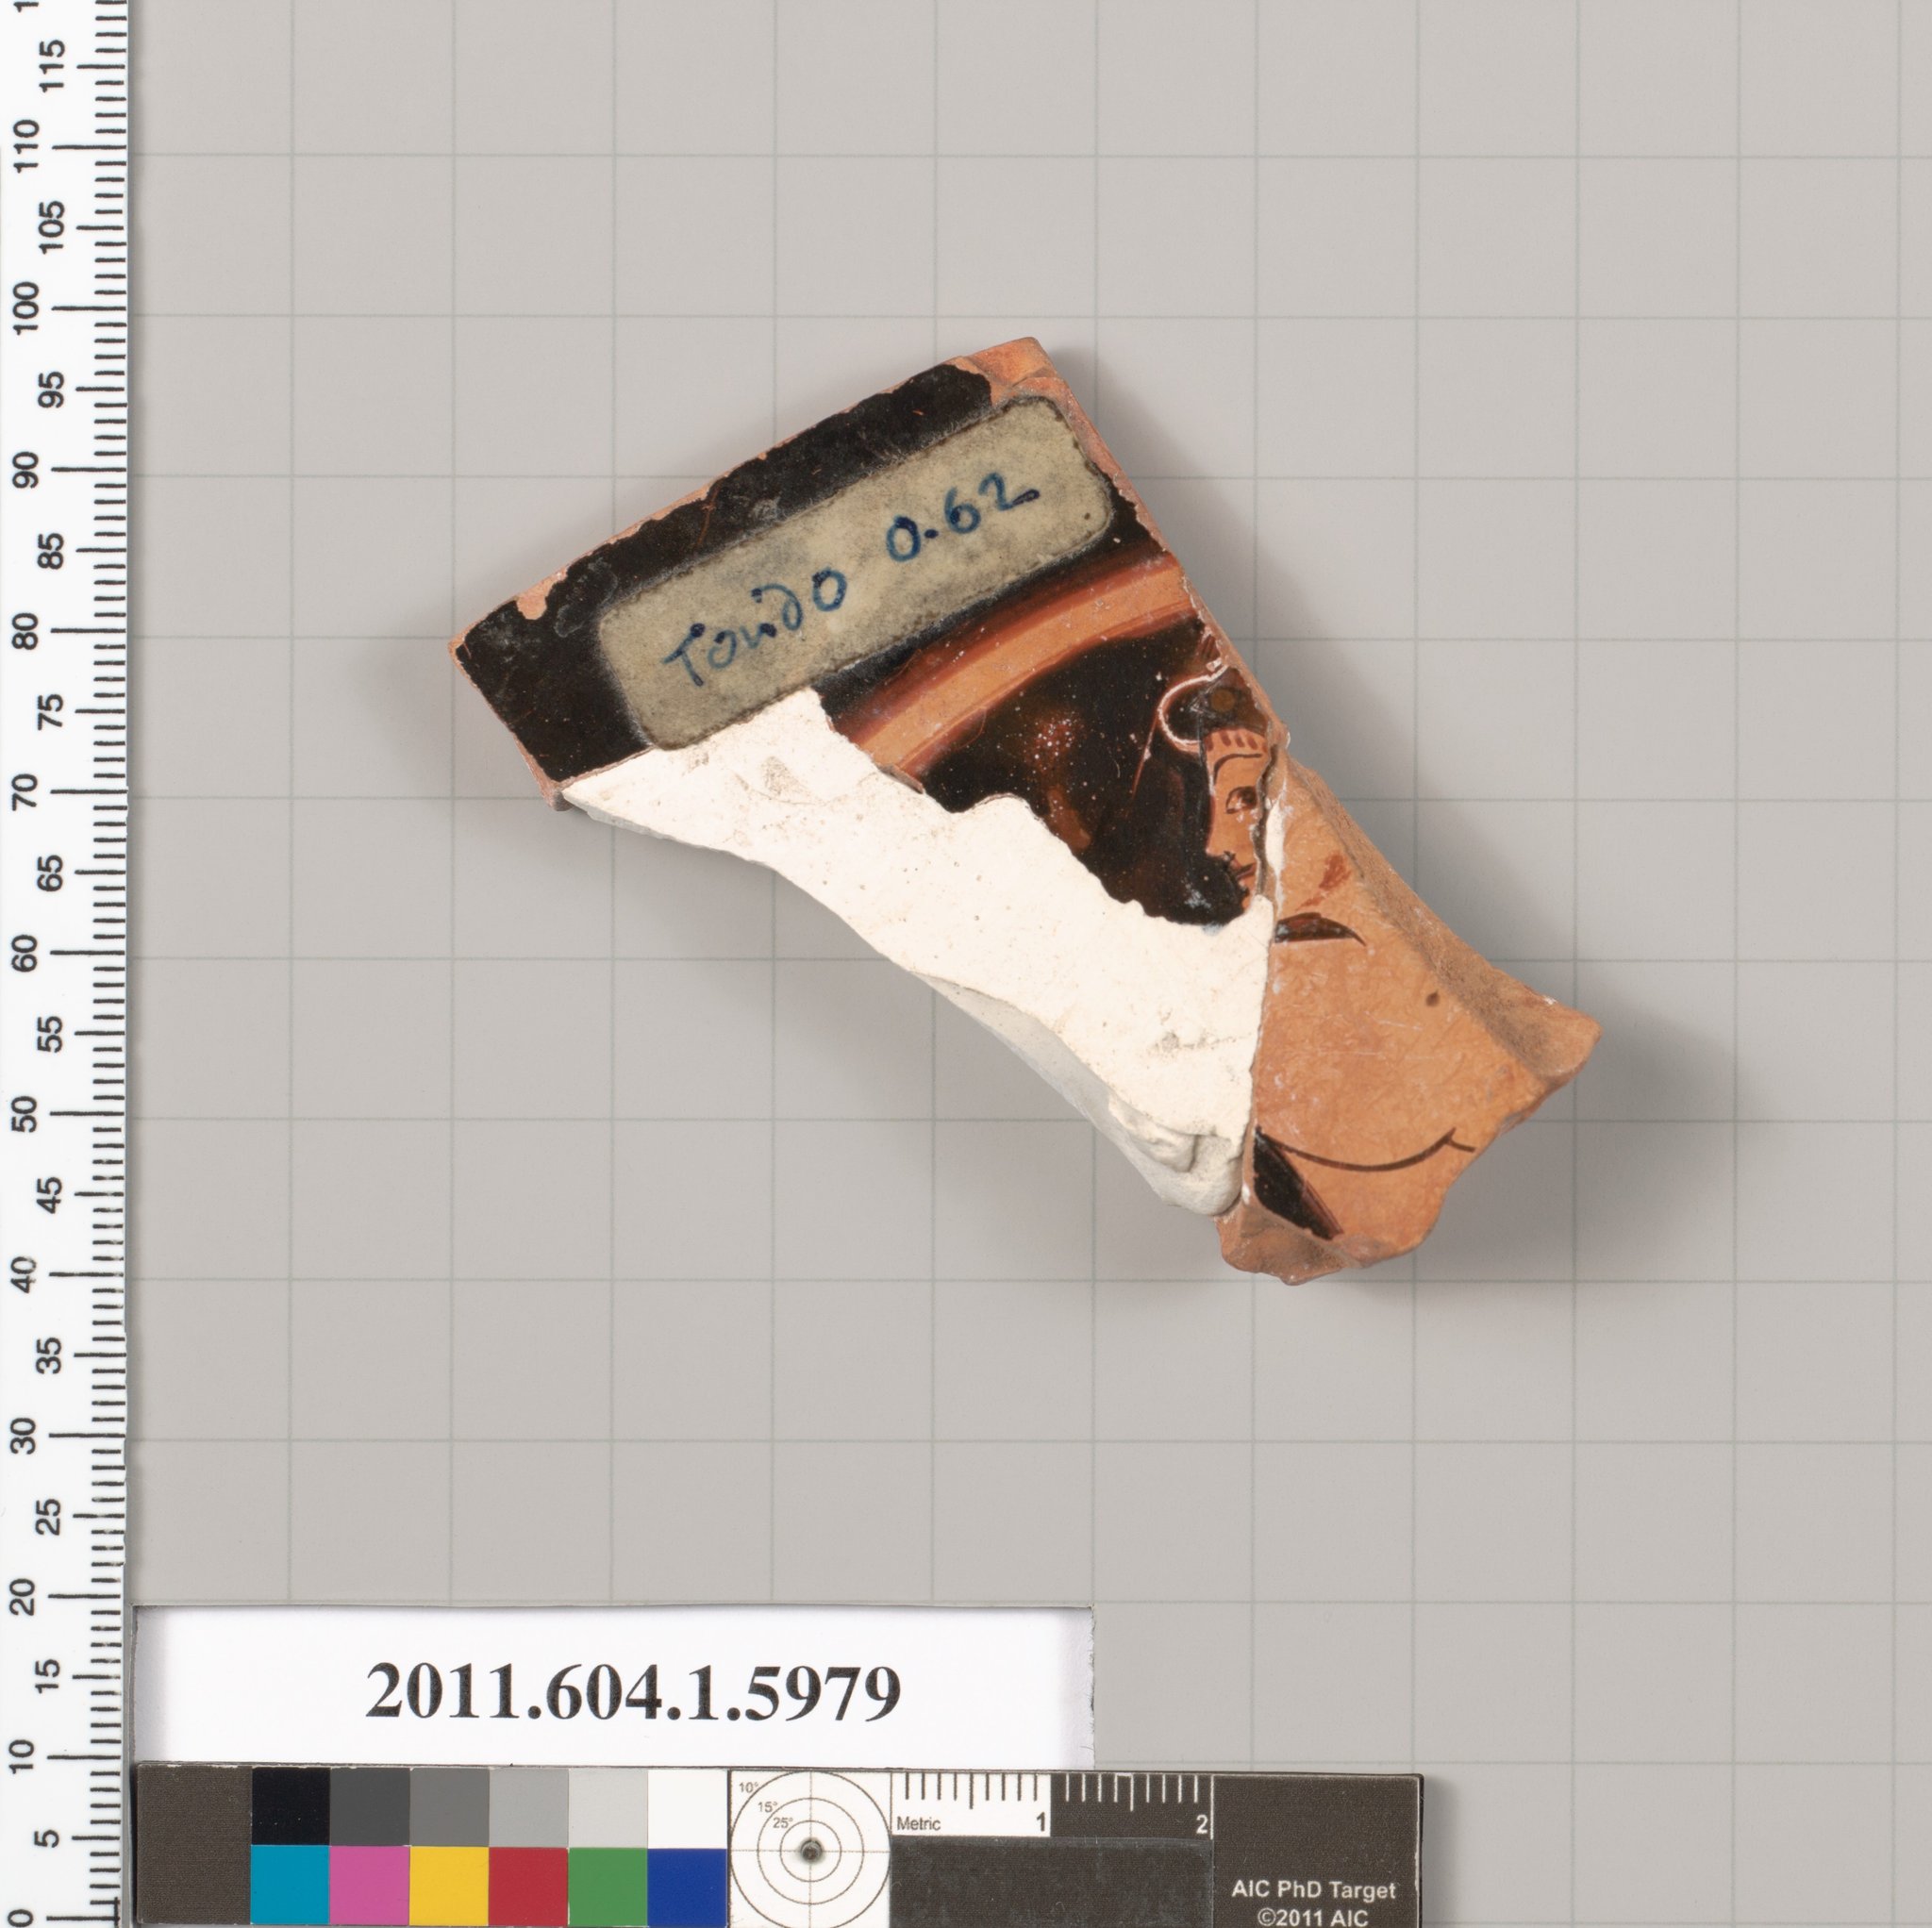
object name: kylix fragment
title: Terracotta fragment of a kylix (drinking cup)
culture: greek, attic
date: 510-500 BCE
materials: terracotta